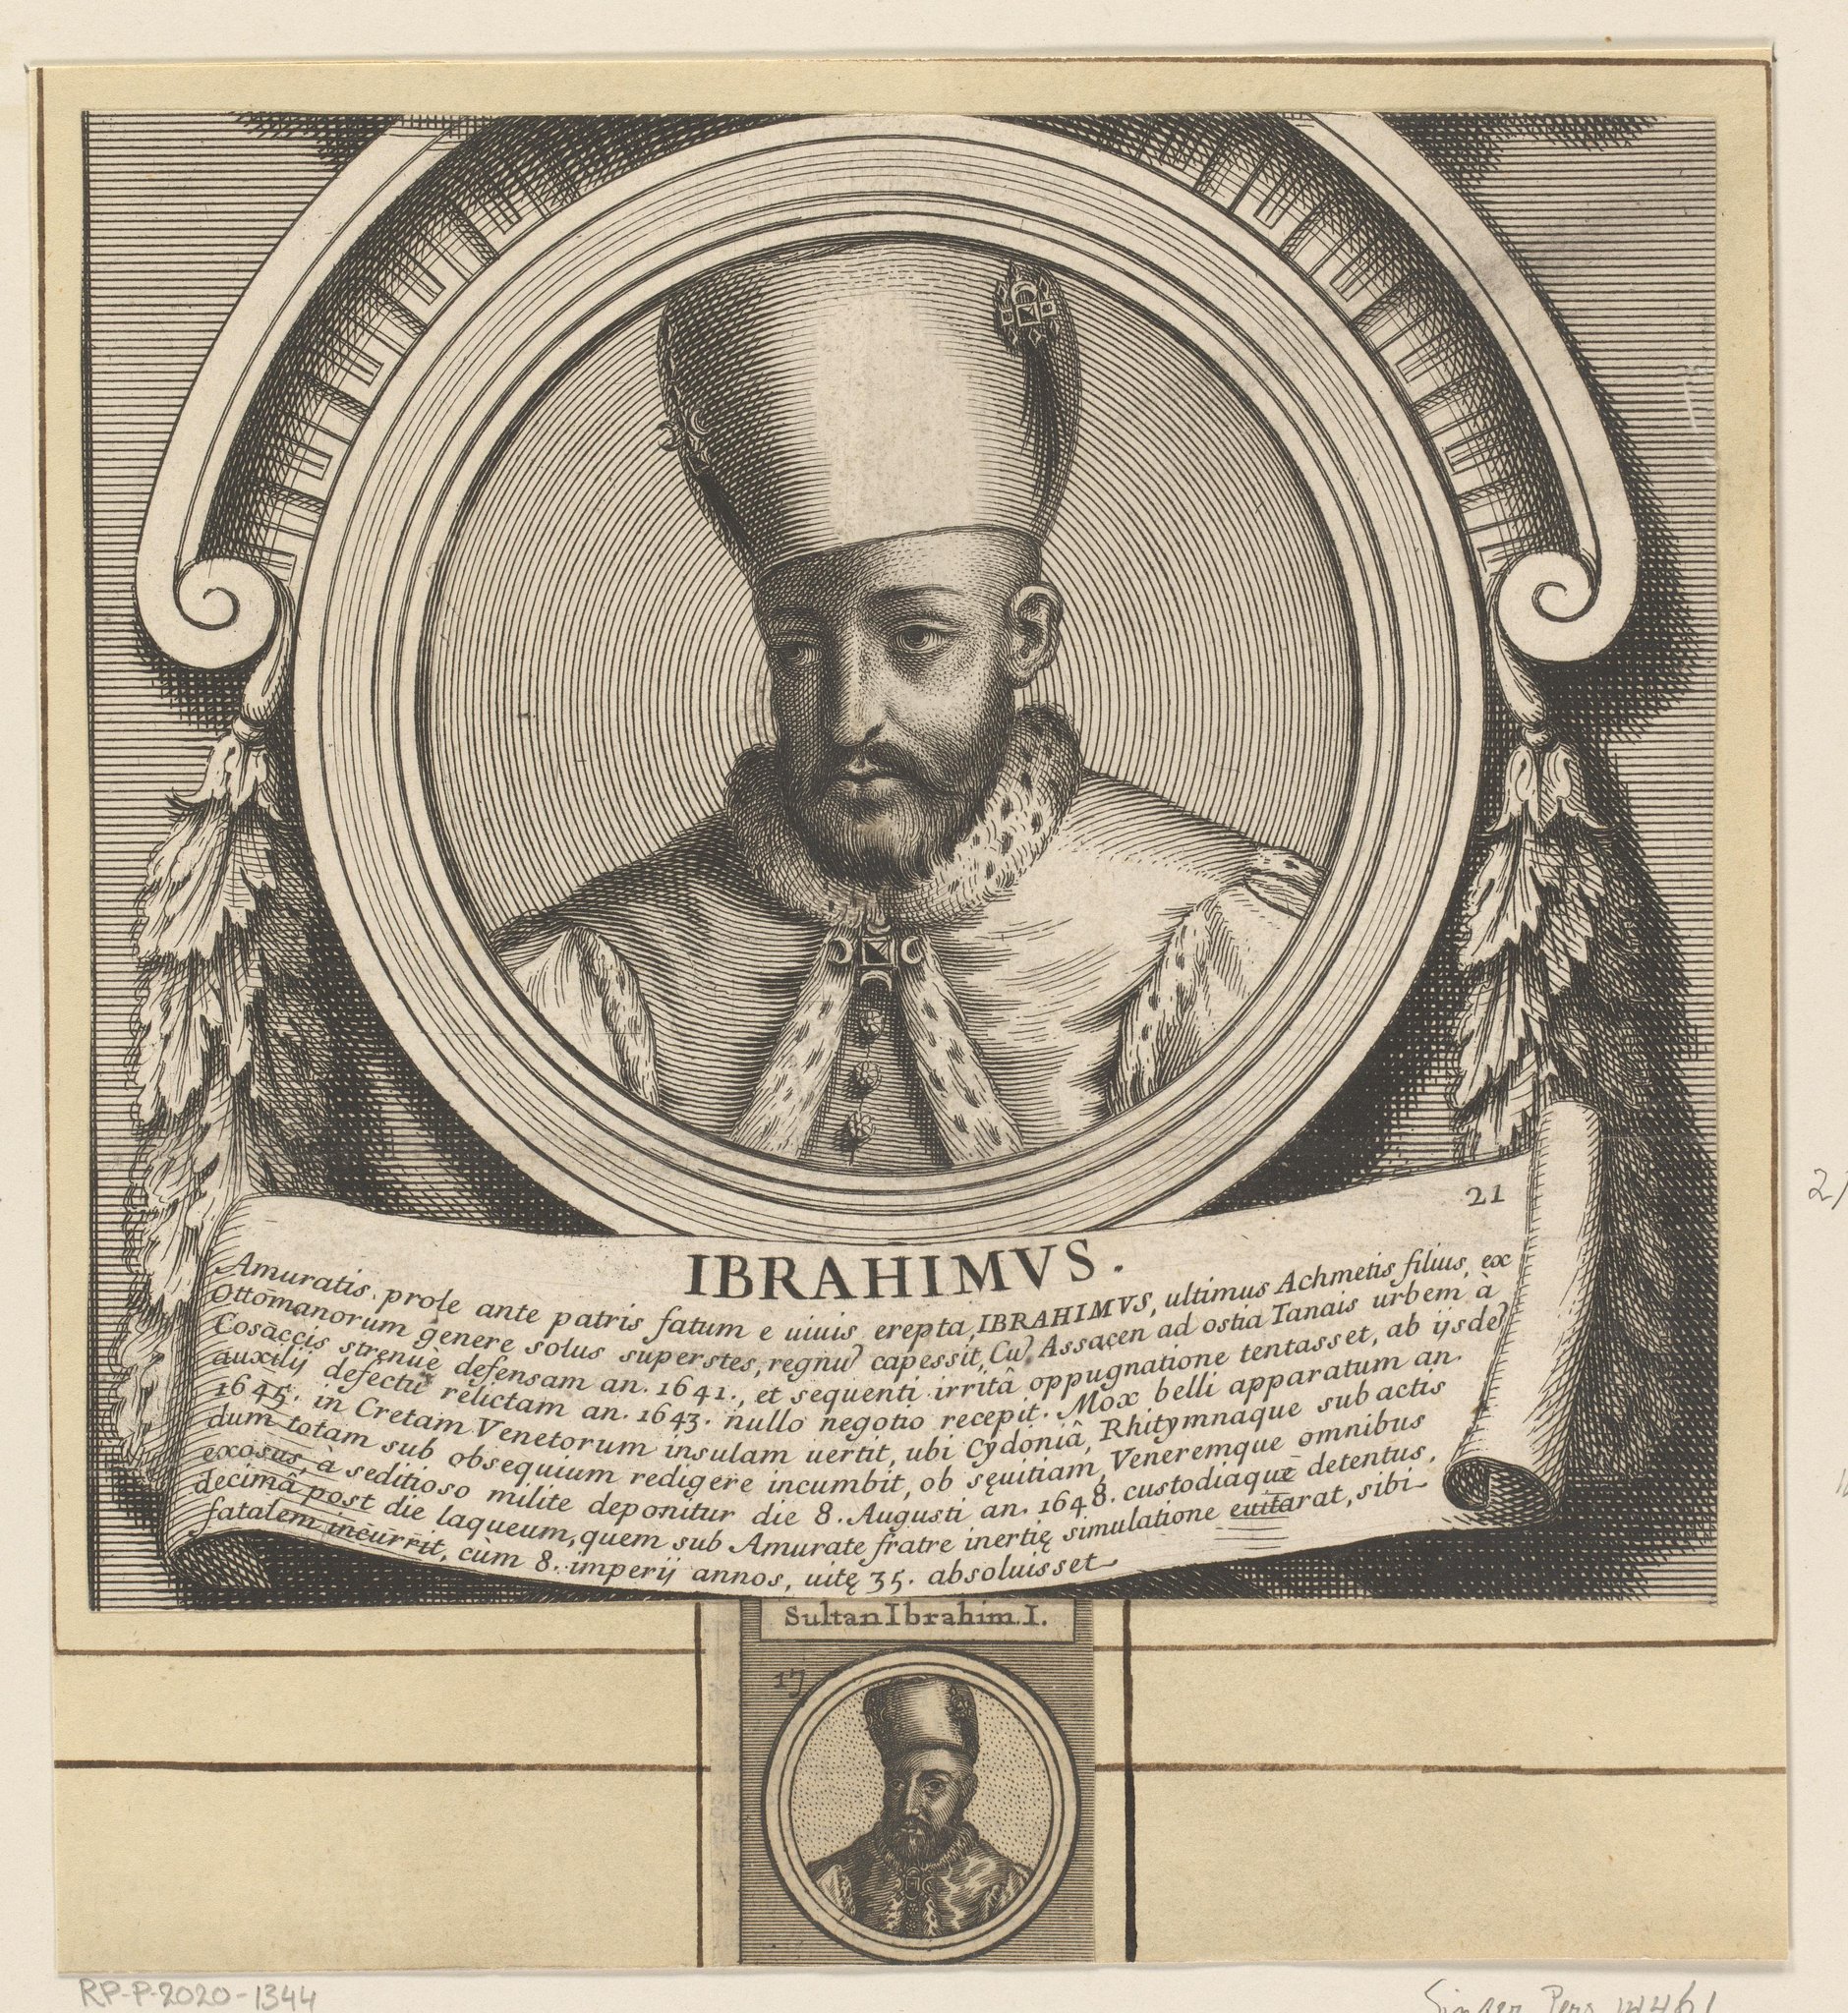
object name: print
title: Ibrahimus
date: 1699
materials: paper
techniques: engraving, etching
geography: rome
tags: historical persons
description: Portret afkomstig van een grote prent, getiteld 'Ottomanorum Principum Effigies ab Ottomano ad Regnantem Mustapham II', bestaande uit meerdere bladen die samengevoegd konden worden, uitgegeven door Giovanni Giacomo de' Rossi in 1699.